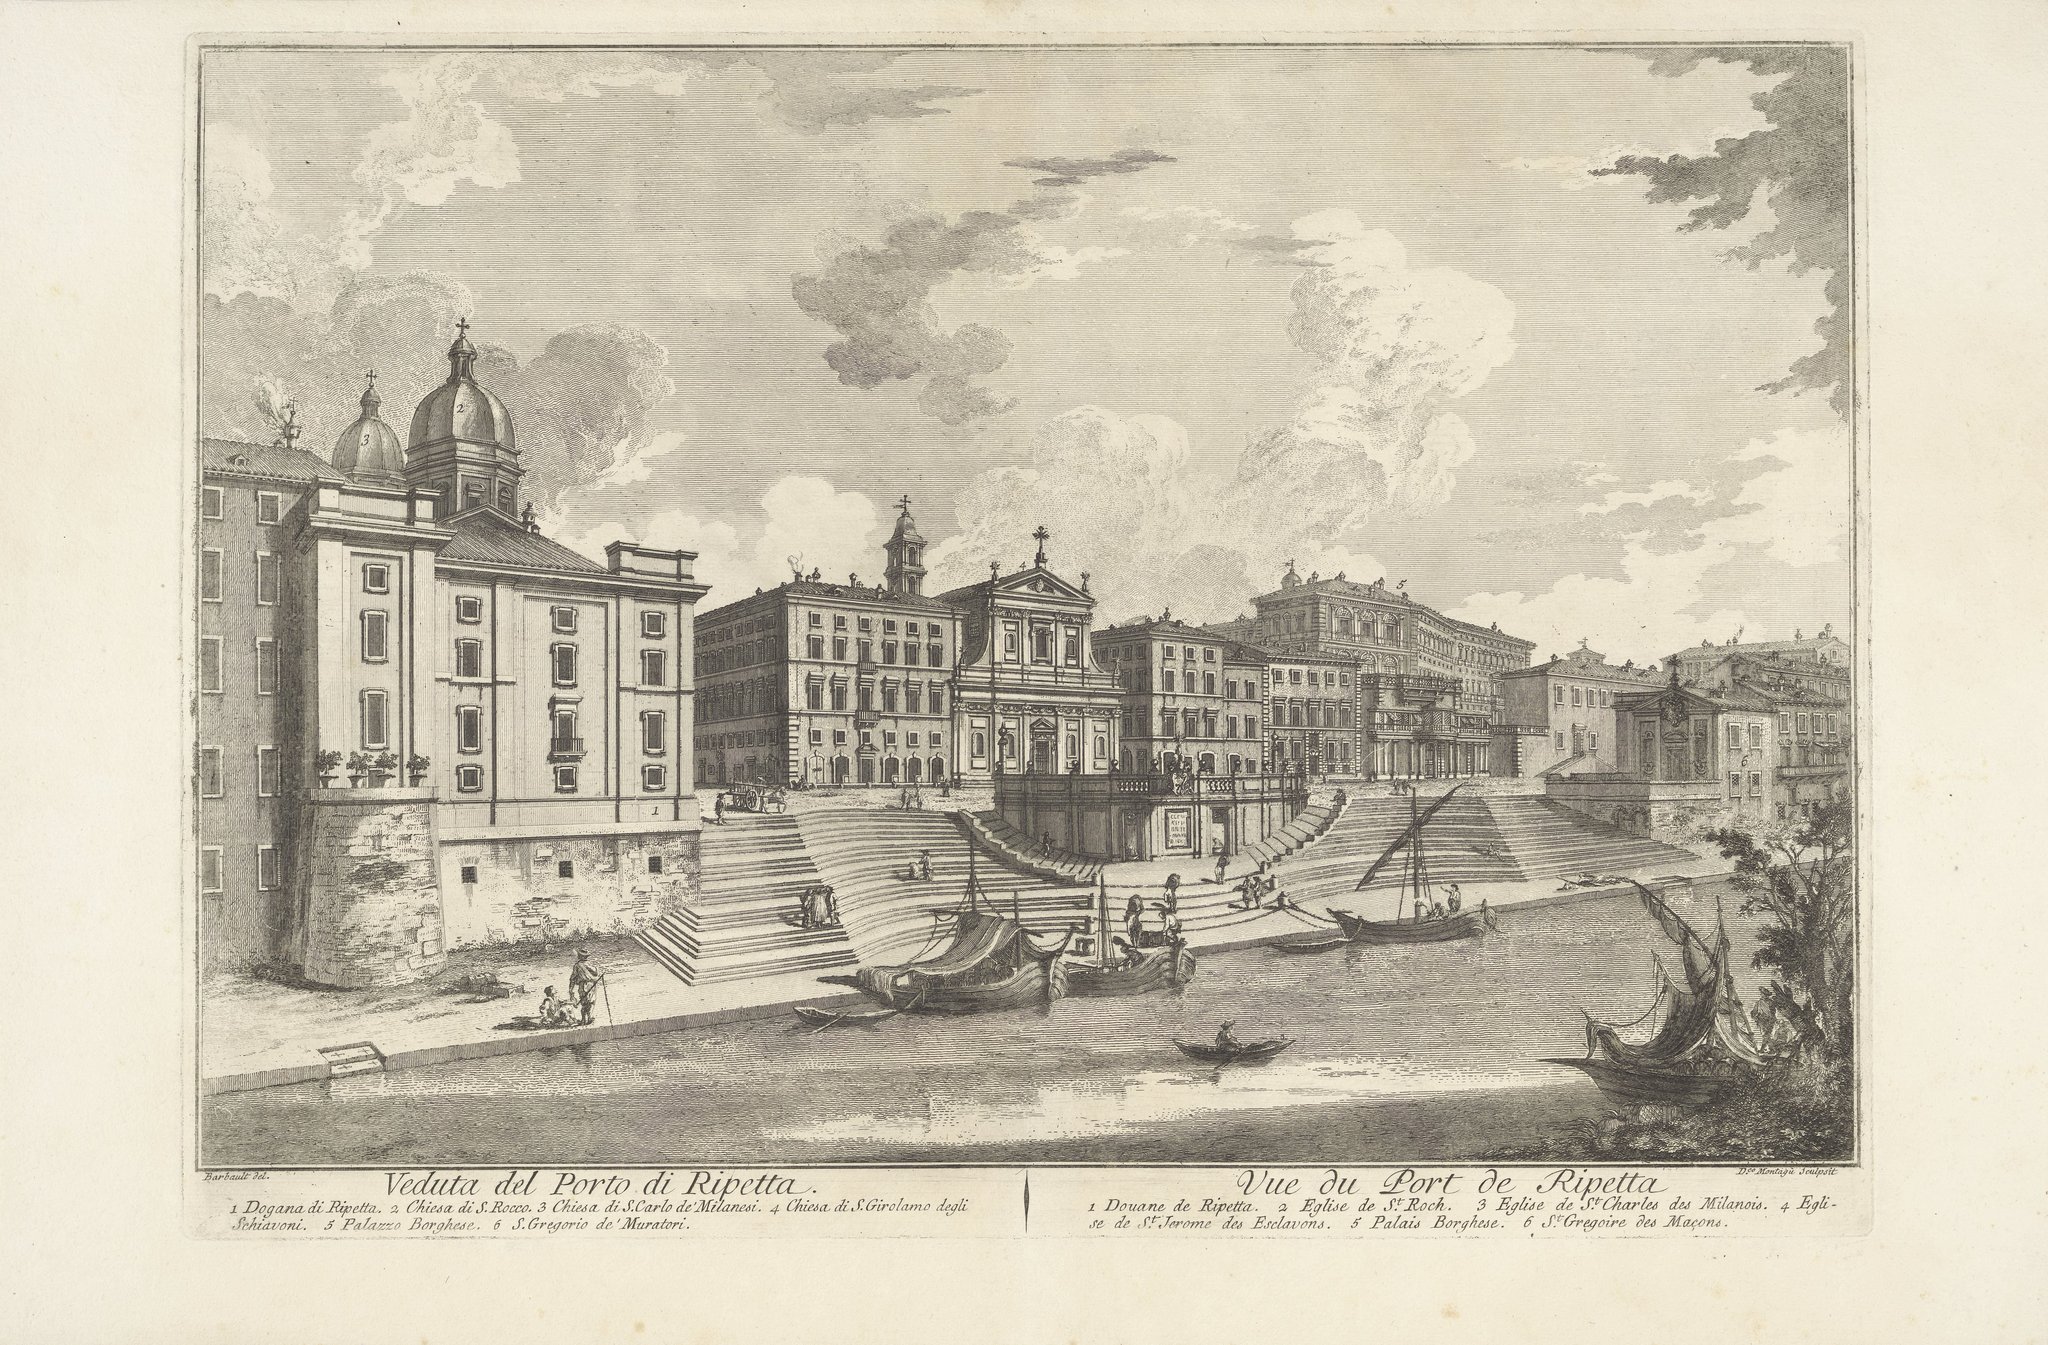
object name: print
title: Porto di Ripetta te Rome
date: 1750-1799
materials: paper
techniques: etching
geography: italy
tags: harbour, city-view, and landscape with man-made constructions, river, church (exterior), rome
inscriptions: collector's mark: Lugt 2228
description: Gezicht op de Porto di Ripetta in de Tiber te Rome bij de Chiesa di San Girolamo dei Croati. Titels en verklarende lijsten met nummers in het Italiaans en Frans in ondermarge.